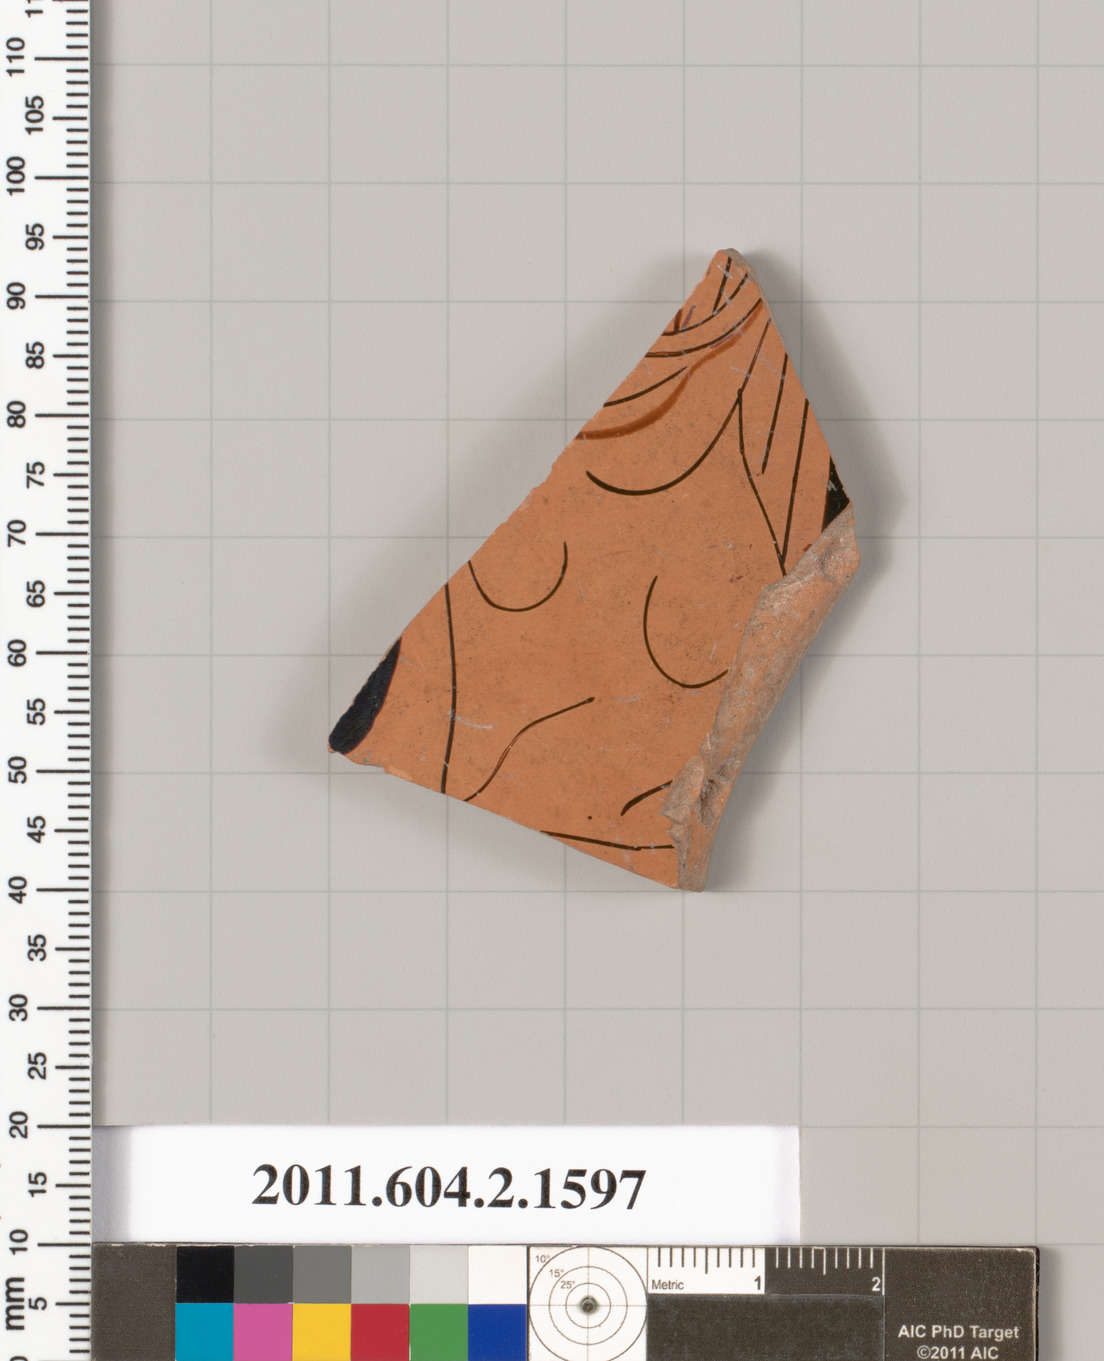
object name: skyphos fragment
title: Terracotta fragment of a skyphos (deep drinking cup)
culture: greek, attic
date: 460-440 BCE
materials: terracotta